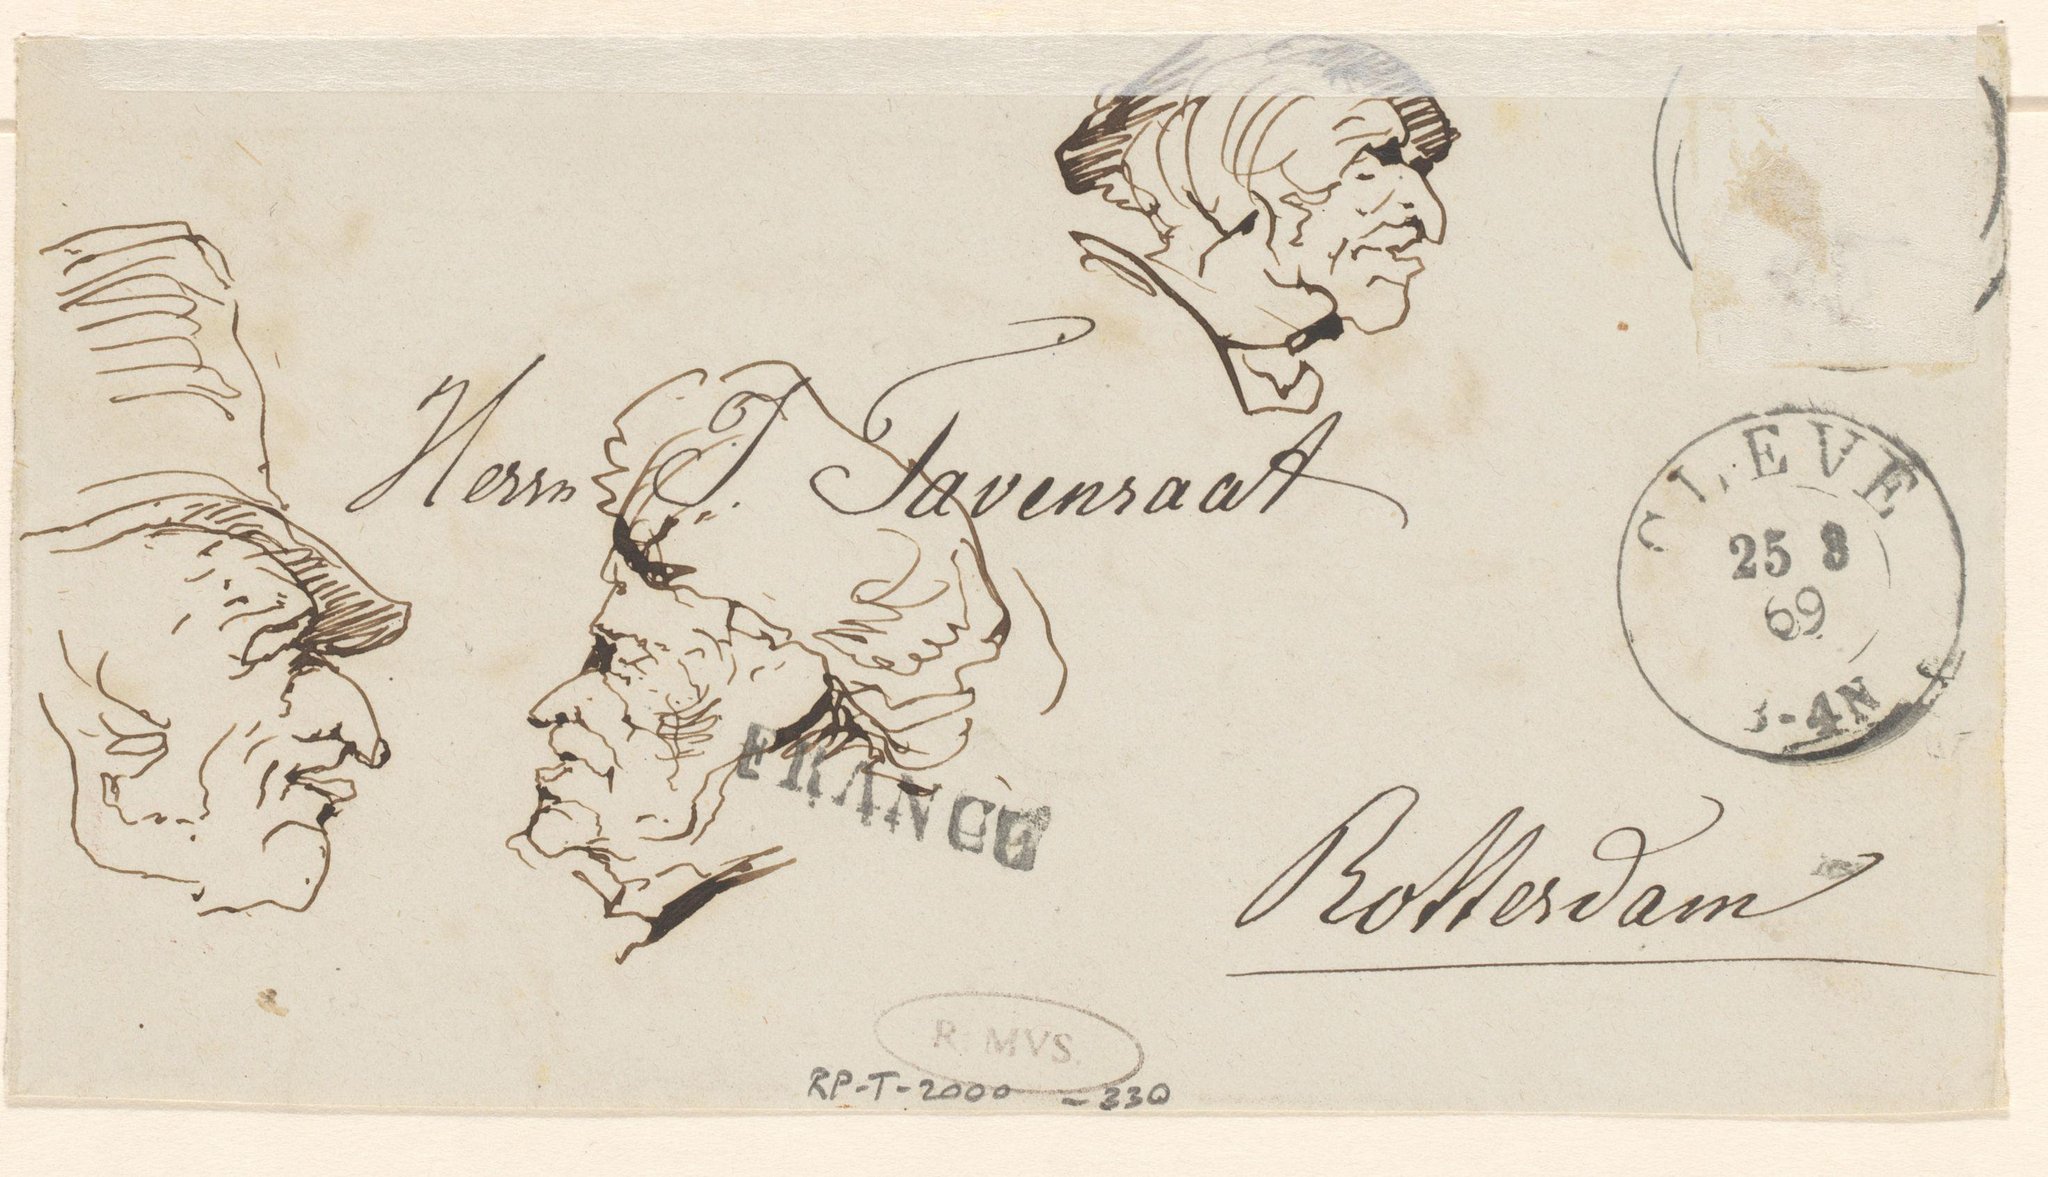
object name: drawing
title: Koppen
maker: johannes tavenraat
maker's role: draughtsman, painter, print maker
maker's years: 1809-1881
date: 1869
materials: ink, paper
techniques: pen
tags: caricatures (human types)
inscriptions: collector's mark: Lugt 2228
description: Karikaturale koppen. Getekend op een deel van een envelop gericht aan J. Tavenraat en gestempeld 25 8 69.